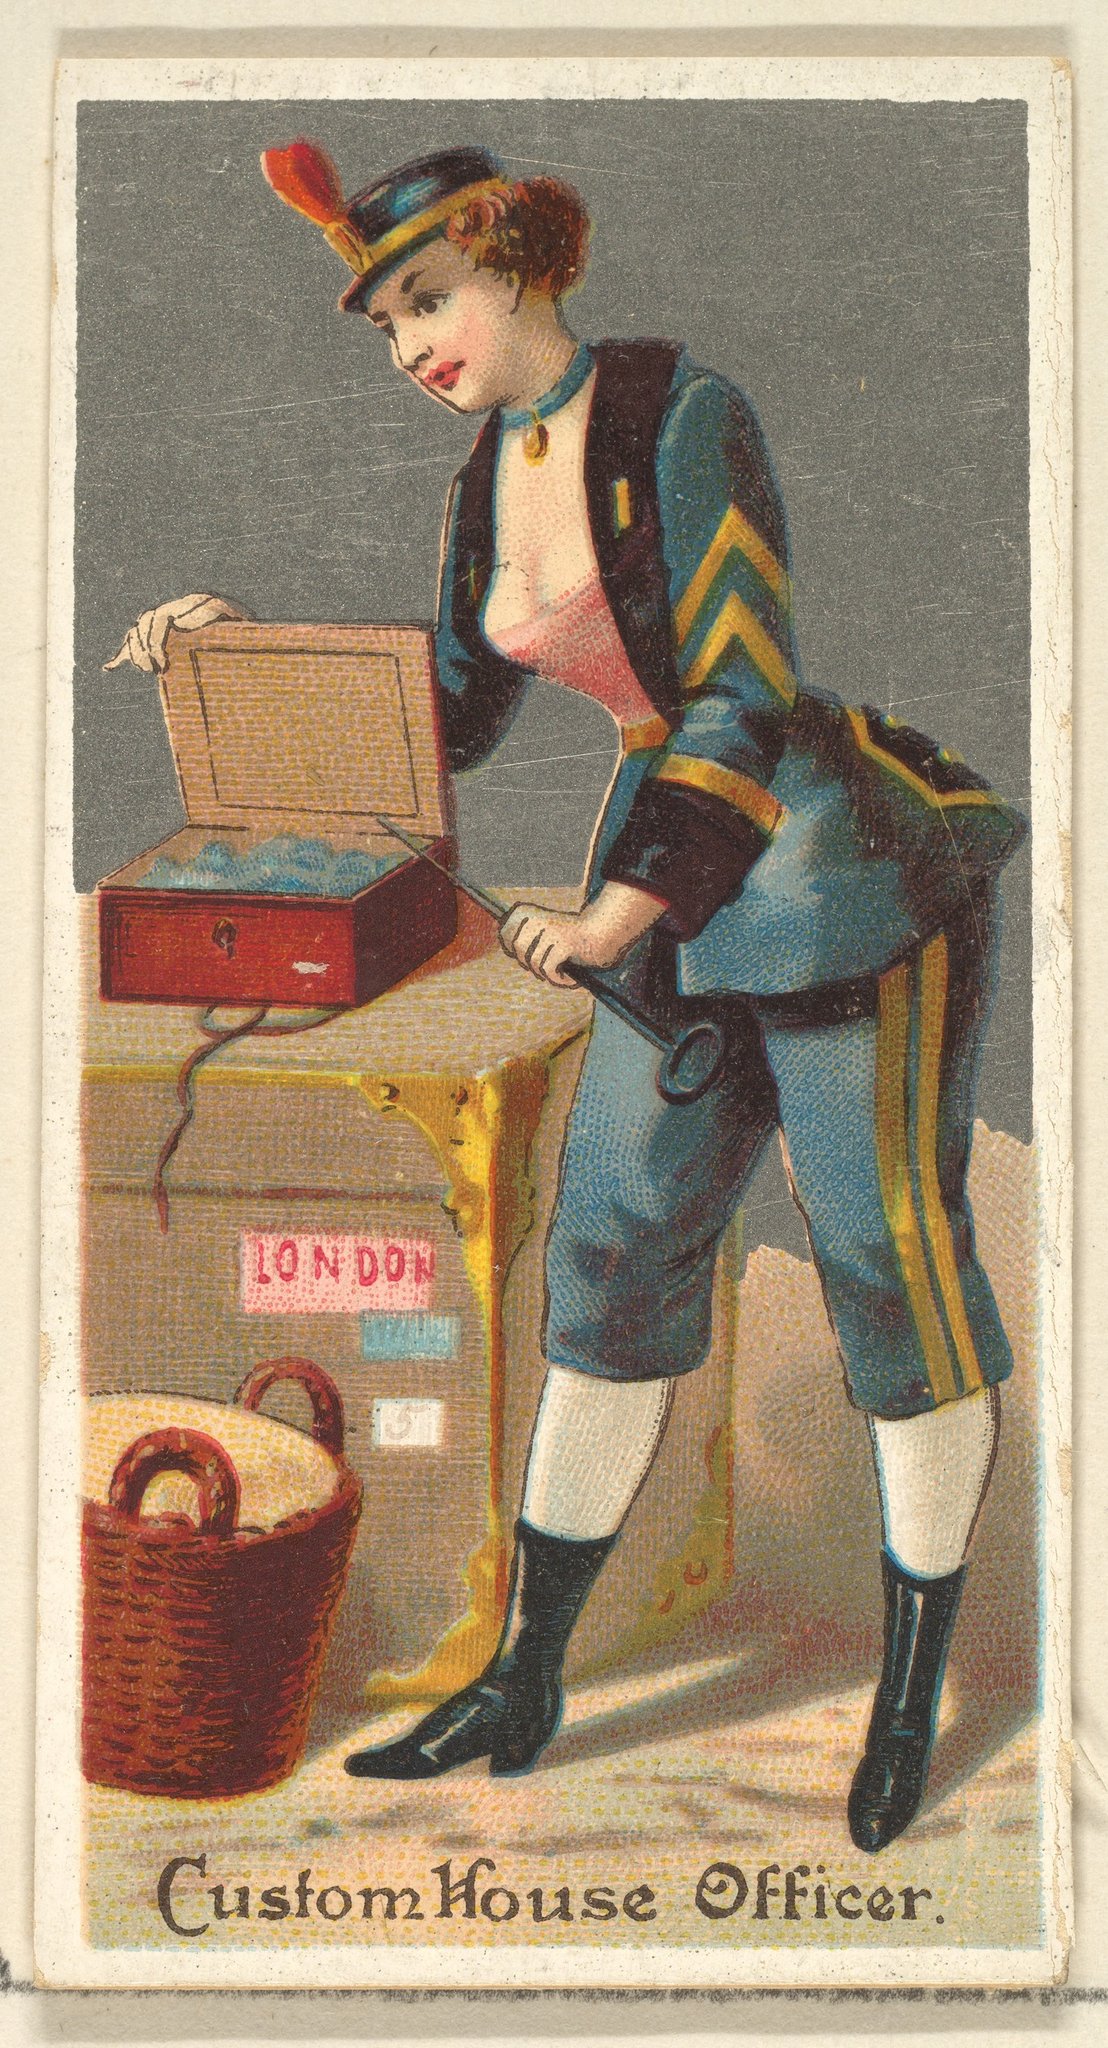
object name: print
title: Custom House Officer, from the Occupations for Women series (N166) for Old Judge and Dogs Head Cigarettes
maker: goodwin & company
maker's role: publisher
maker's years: 1850-1950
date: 1887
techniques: color lithograph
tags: women